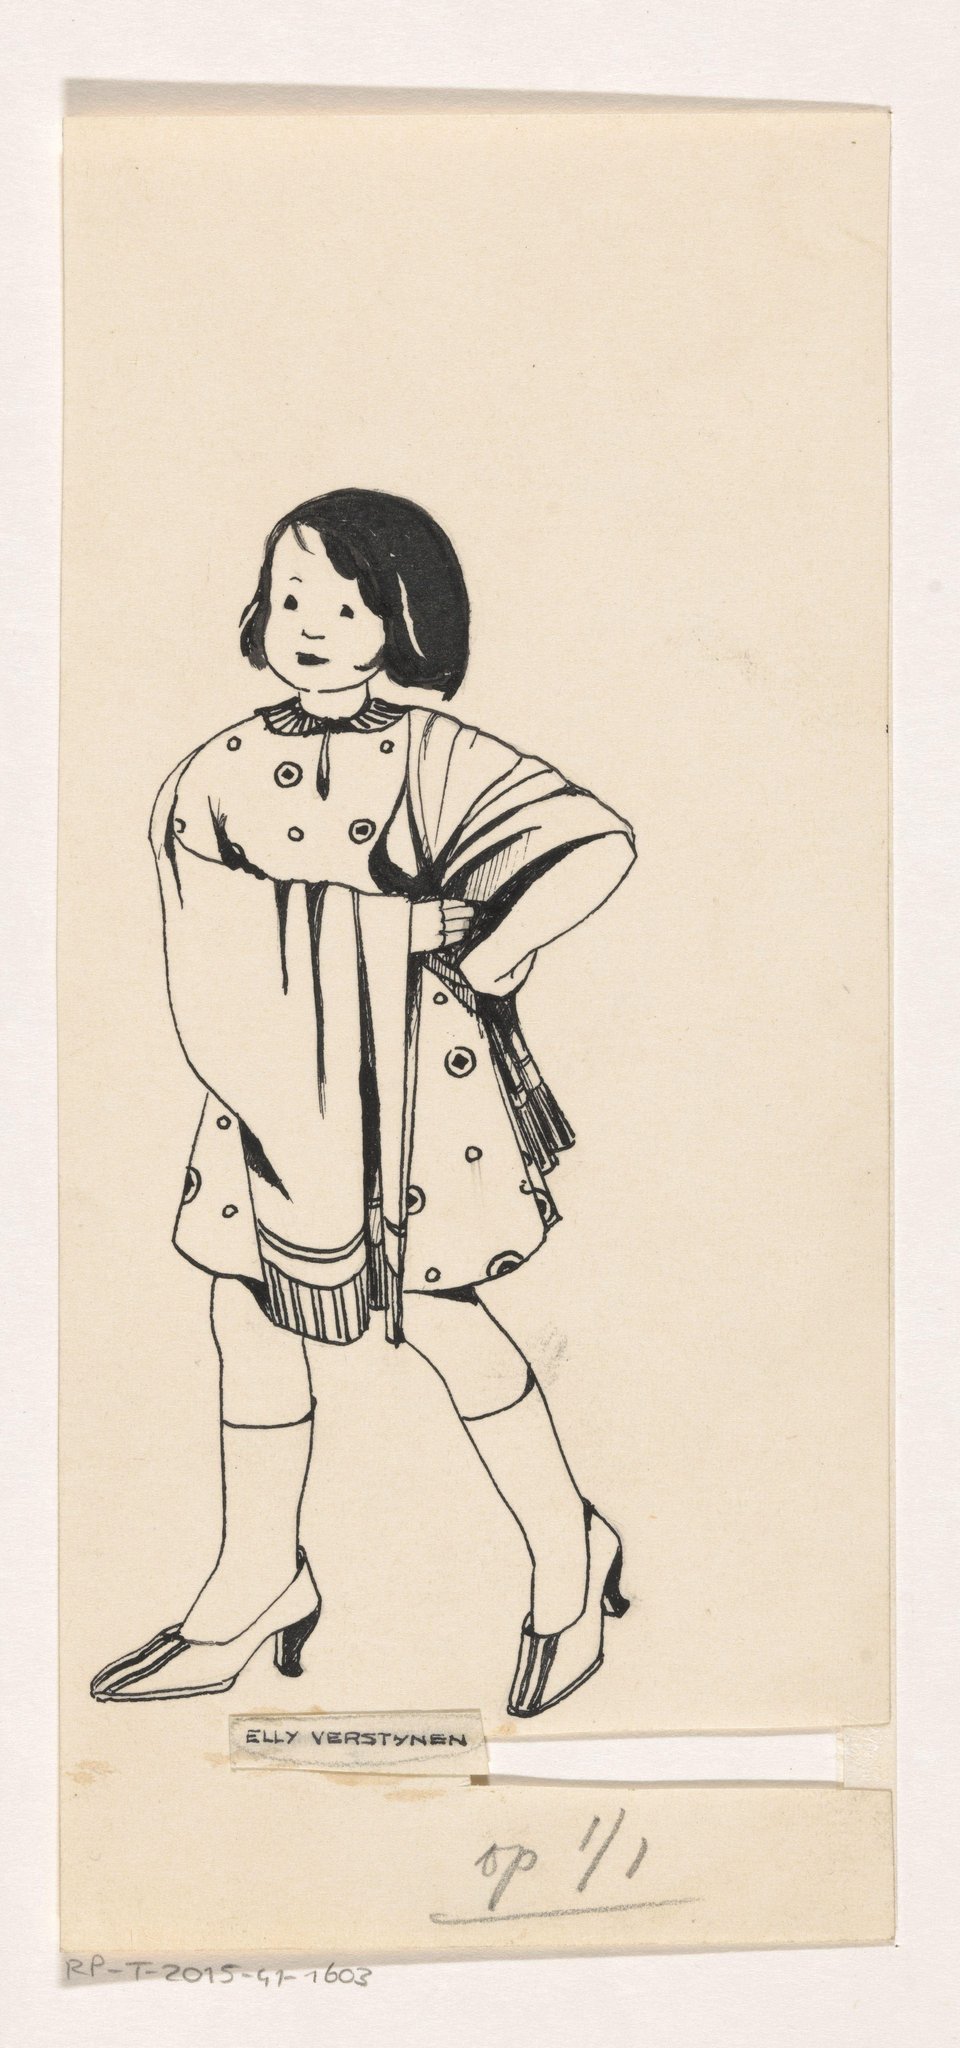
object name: boekillustratie ontwerp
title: Meisje in een jurk met omslagdoek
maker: elly verstijnen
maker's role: draughtsman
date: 1900-1930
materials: ink, paper, pencil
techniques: pen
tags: dress, gown: day dress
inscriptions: :, collector's mark: Lugt 2228, signature: ‘ELLY VERSTYNEN’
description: Verso een potloodtekening van hetzelfde meisje.